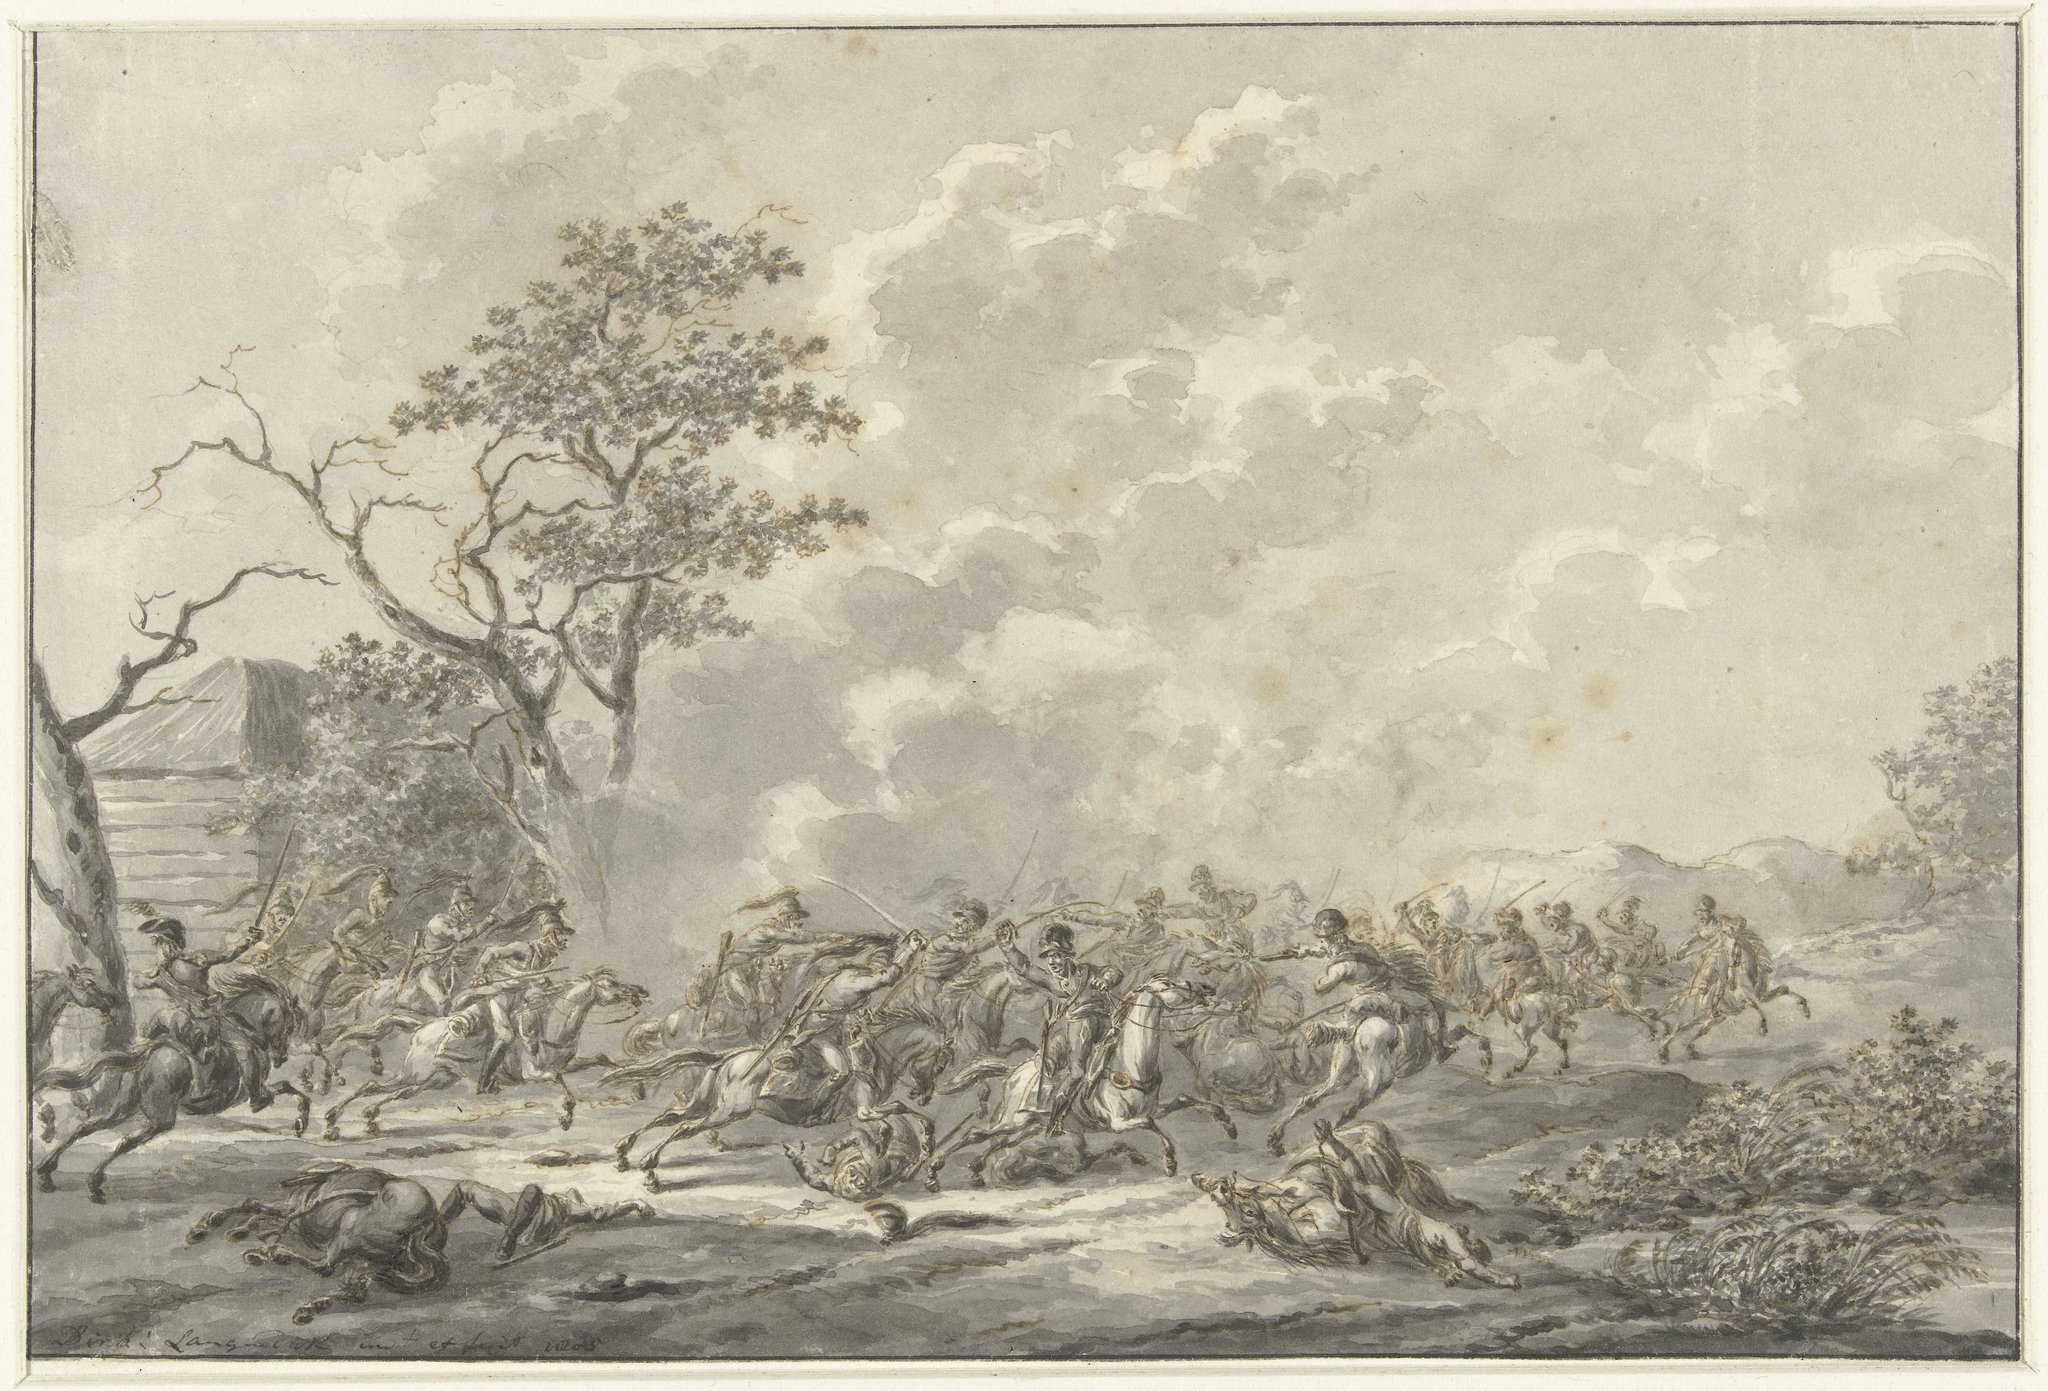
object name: drawing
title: Ruitergevecht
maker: dirk langendijk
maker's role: draughtsman, painter, print maker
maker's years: 1748-1805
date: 1805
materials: ink, paper, pencil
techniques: brush, pen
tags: battle (+ cavalry, horsemen)